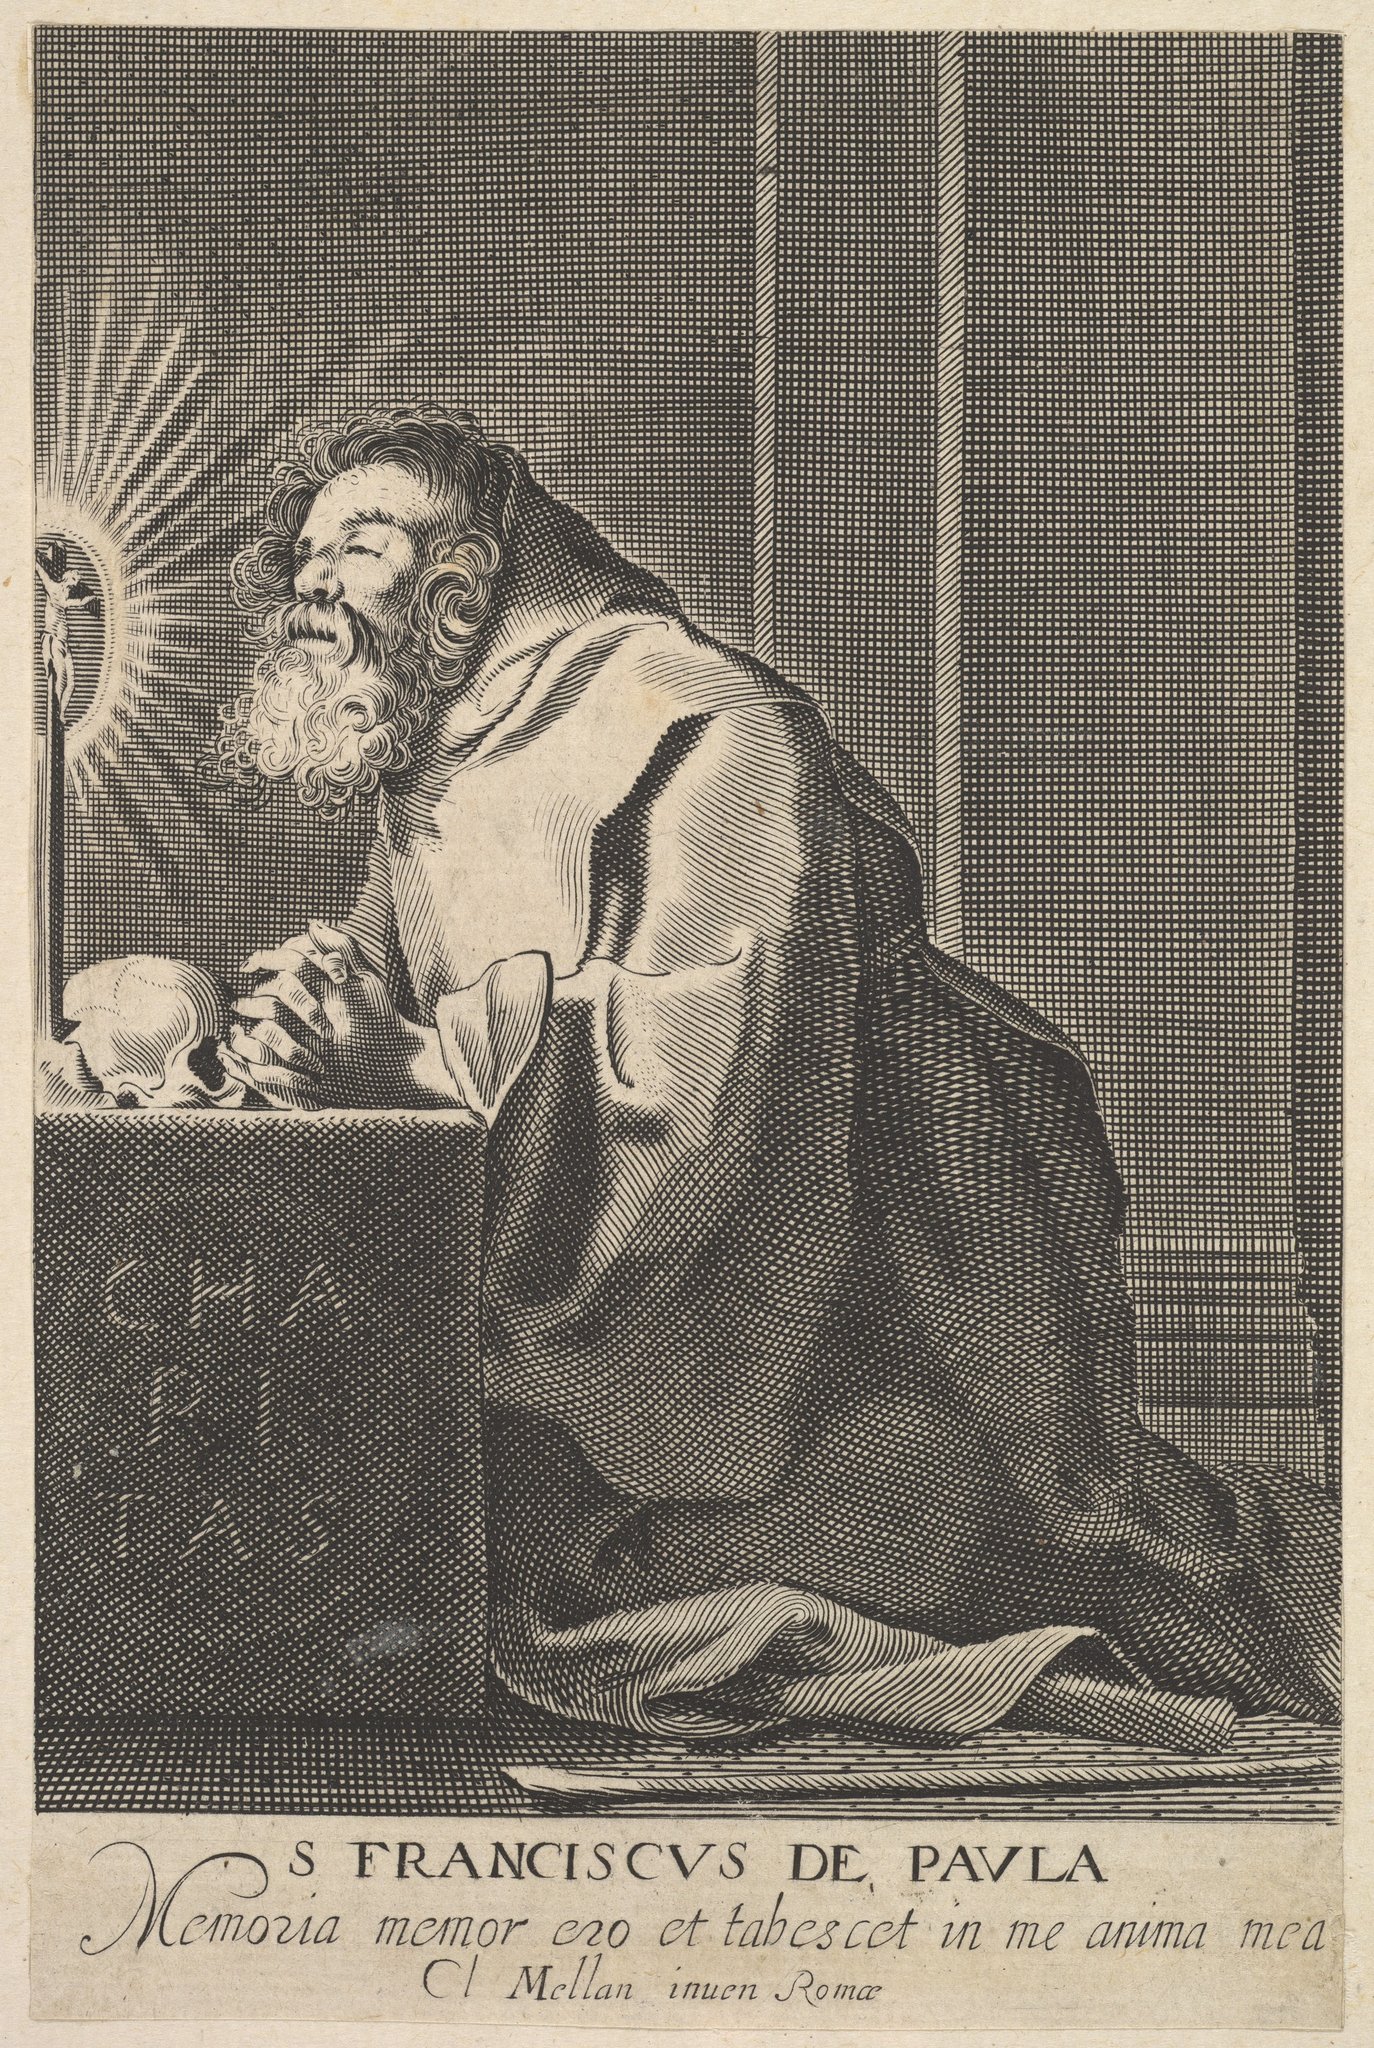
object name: print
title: St. Francis de Paul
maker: anonymous, french, 17th century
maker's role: artist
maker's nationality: french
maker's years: 1600-1700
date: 1627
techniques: engraving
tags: christ,saints